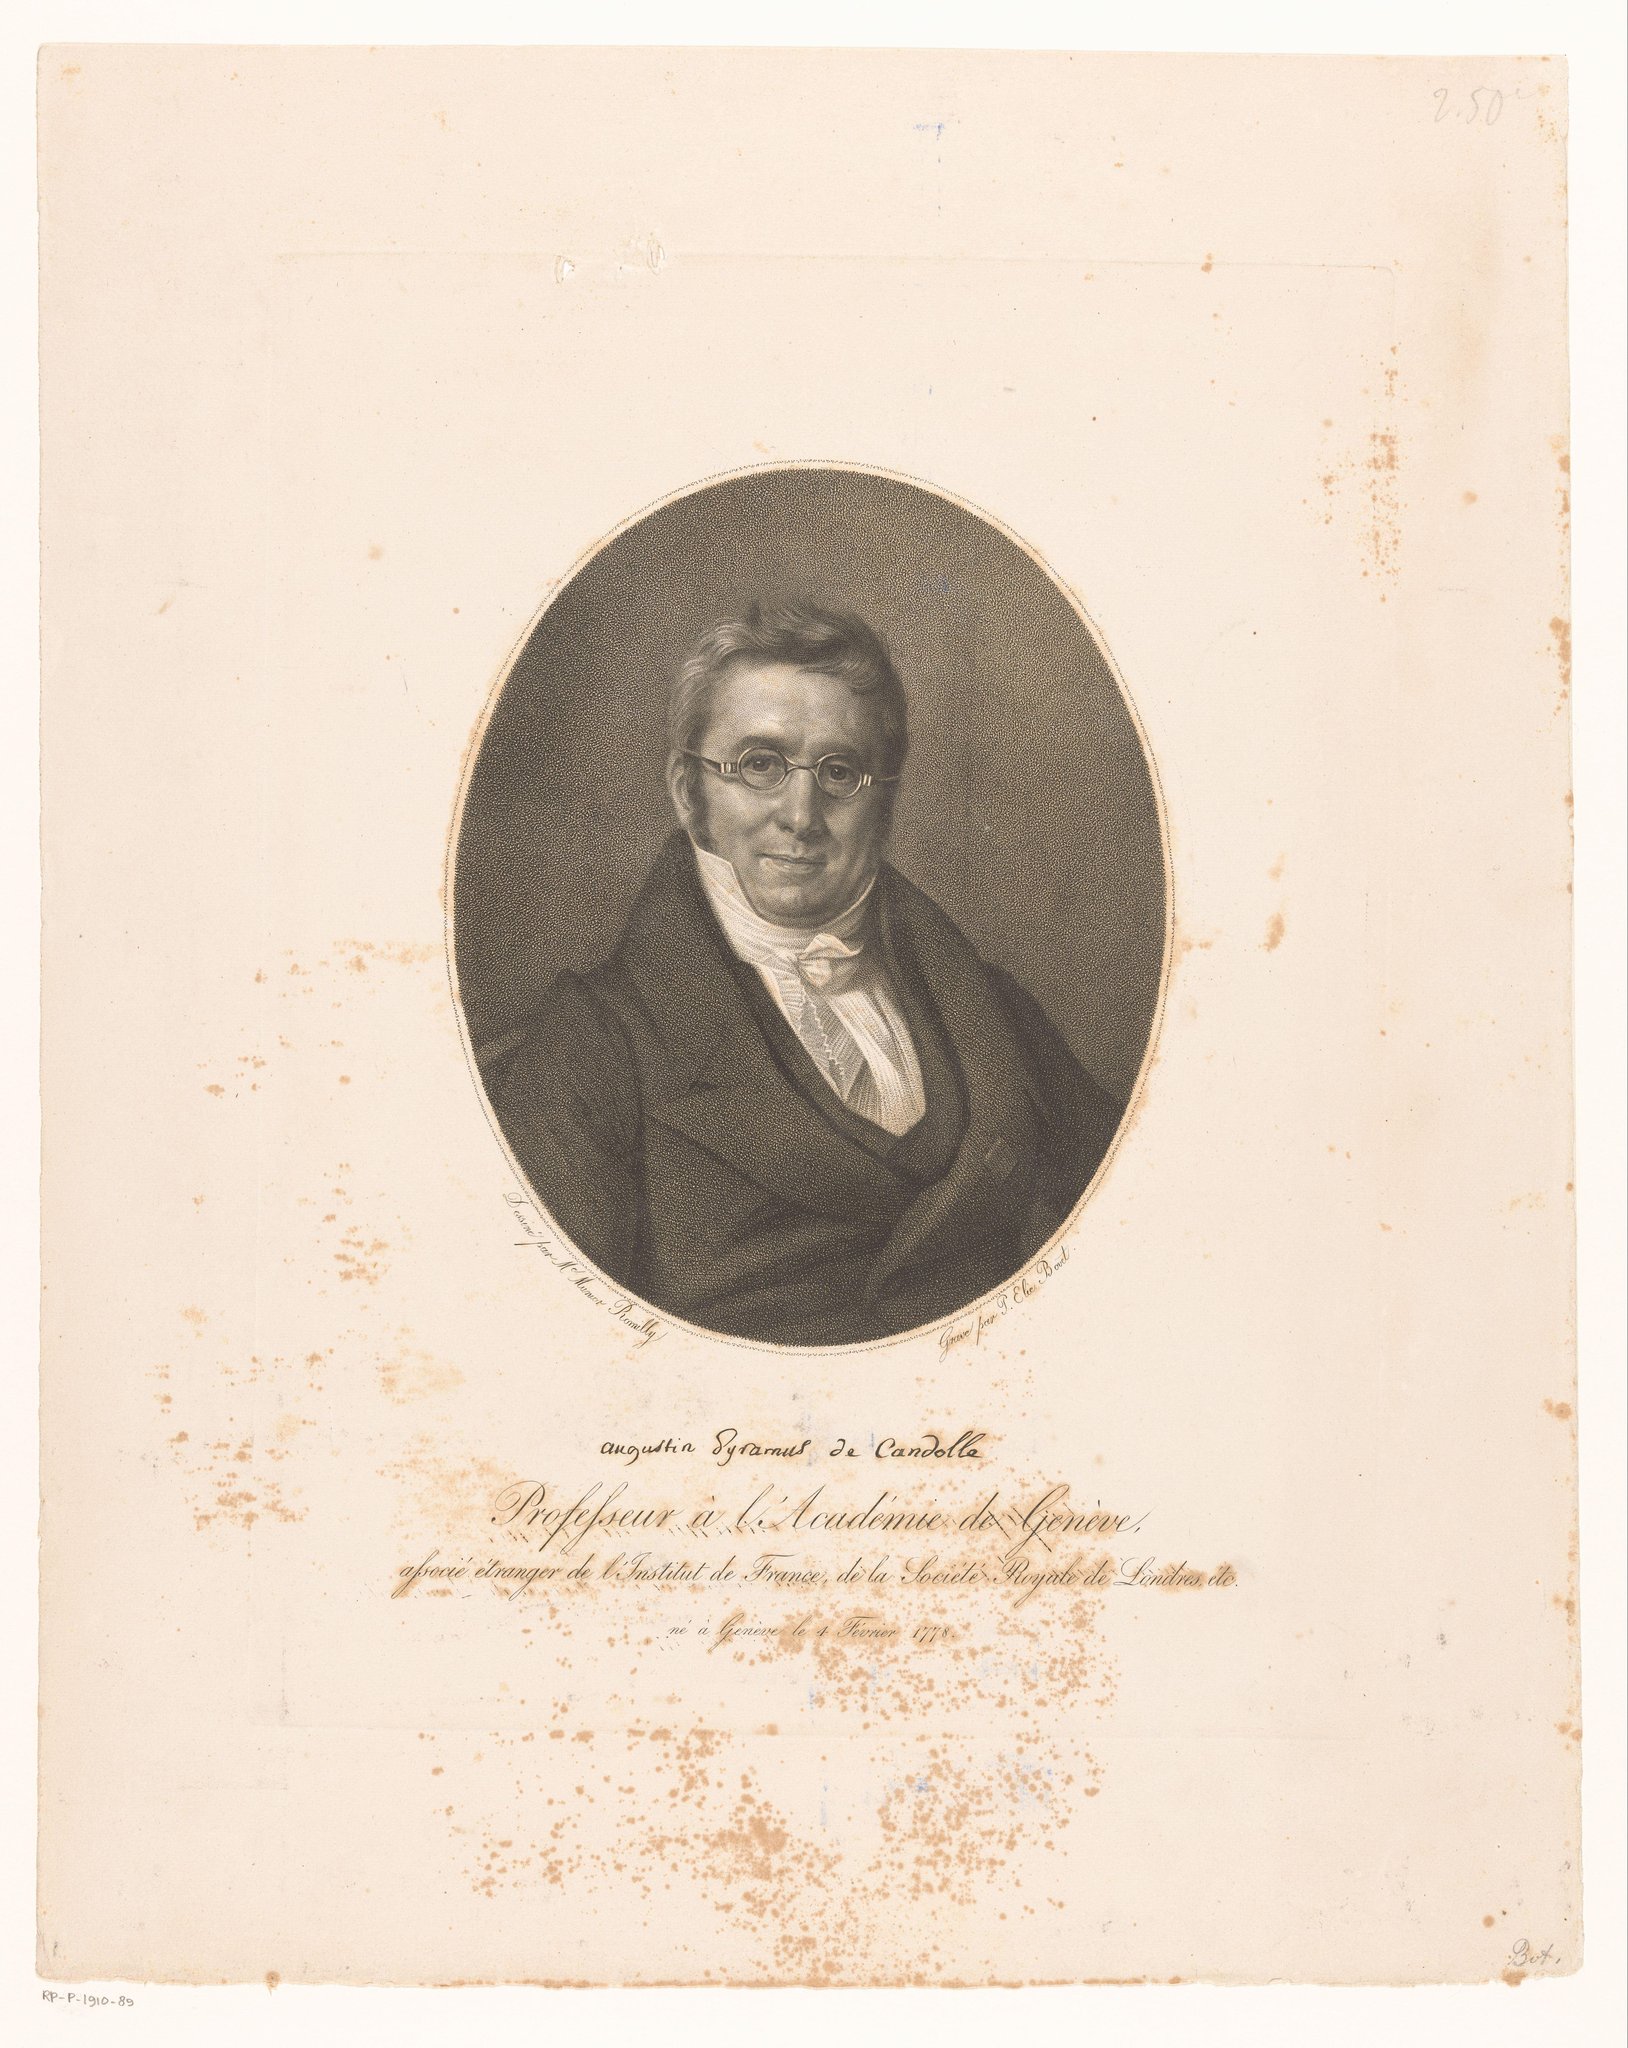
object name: print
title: Portret van Alphonse Pyramus de Candolle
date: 1811-1875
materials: paper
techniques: engraving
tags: eyeglasses, spectacles, historical persons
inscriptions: collector's mark: Lugt 2228